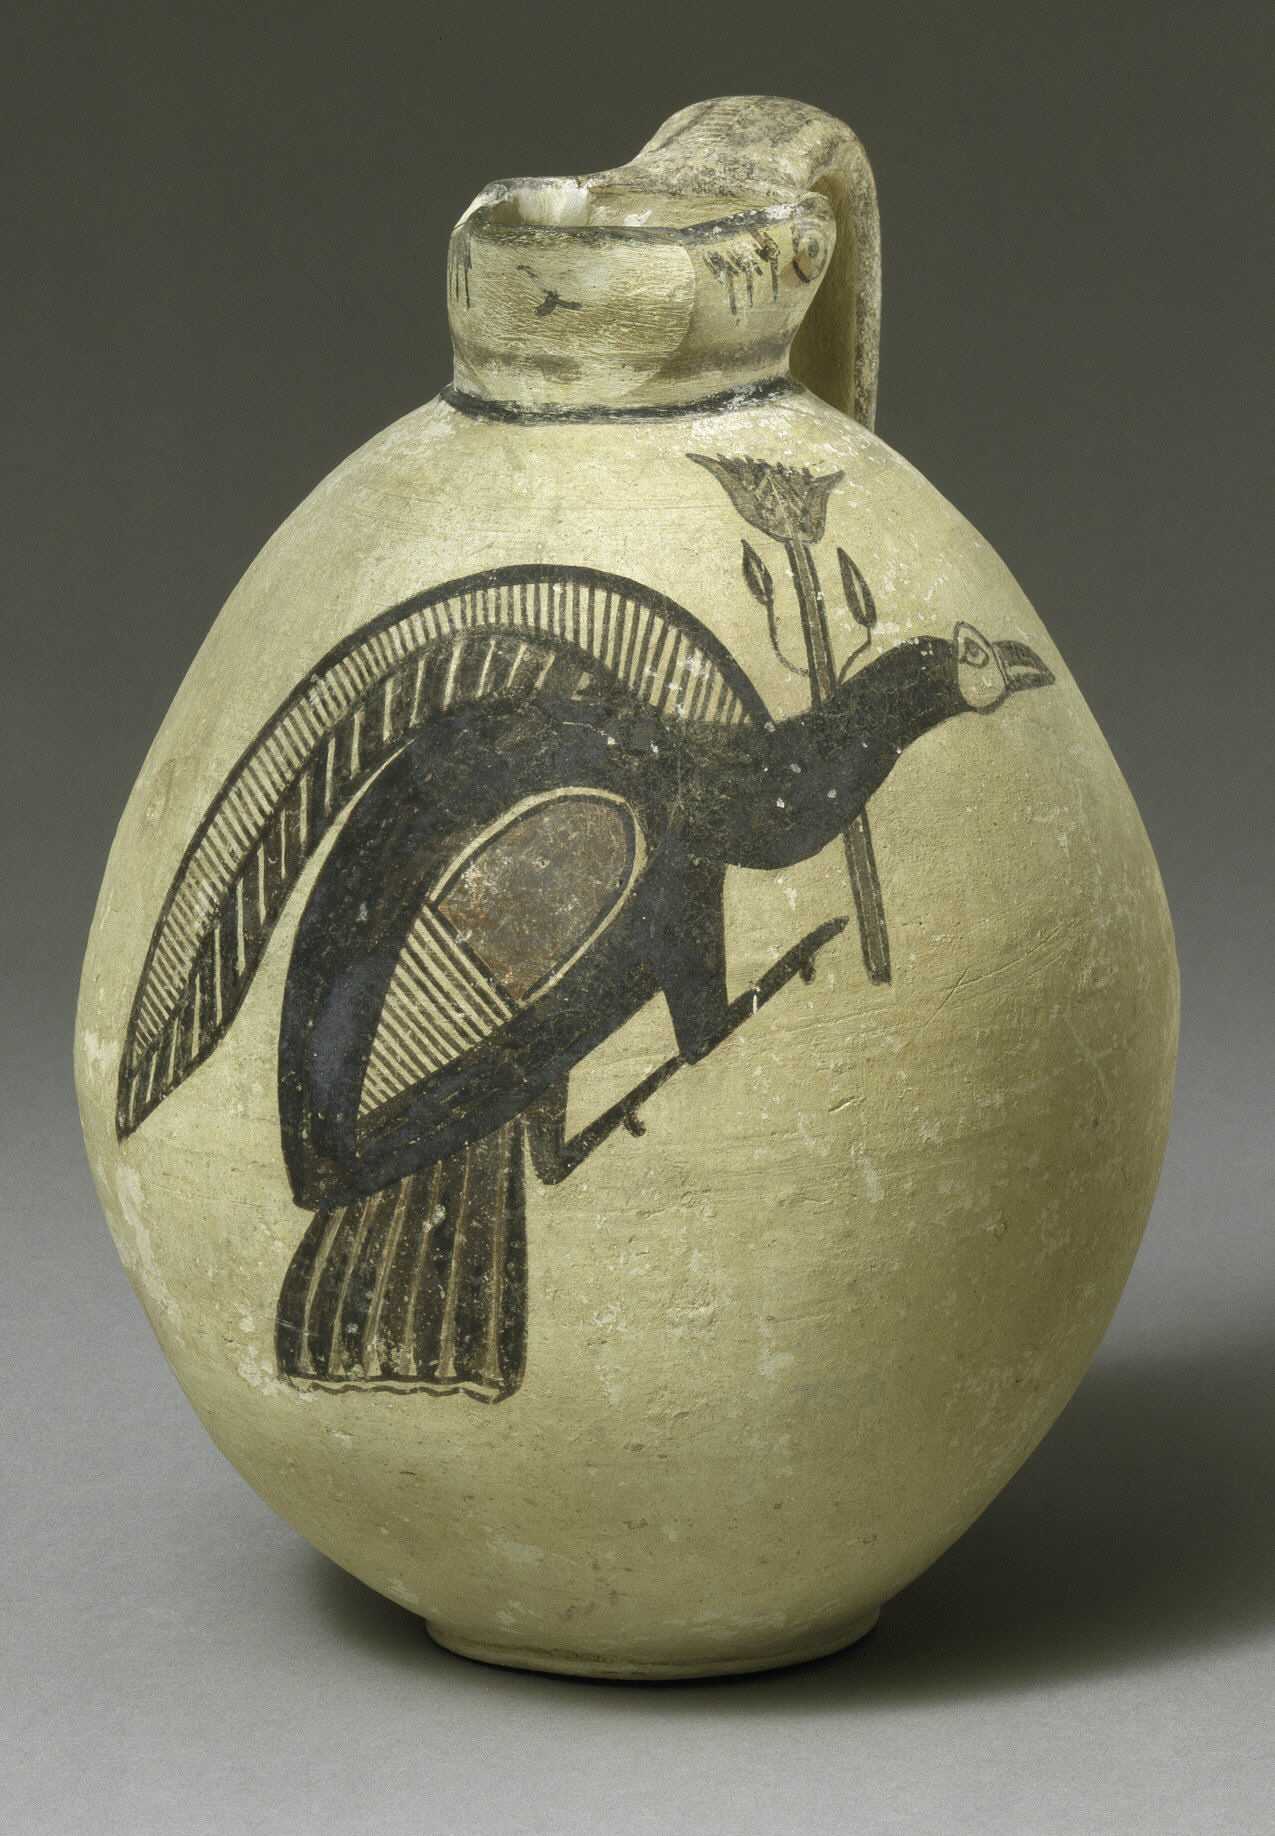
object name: jug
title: Terracotta jug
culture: cypriot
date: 750-600 BCE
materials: terracotta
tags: birds